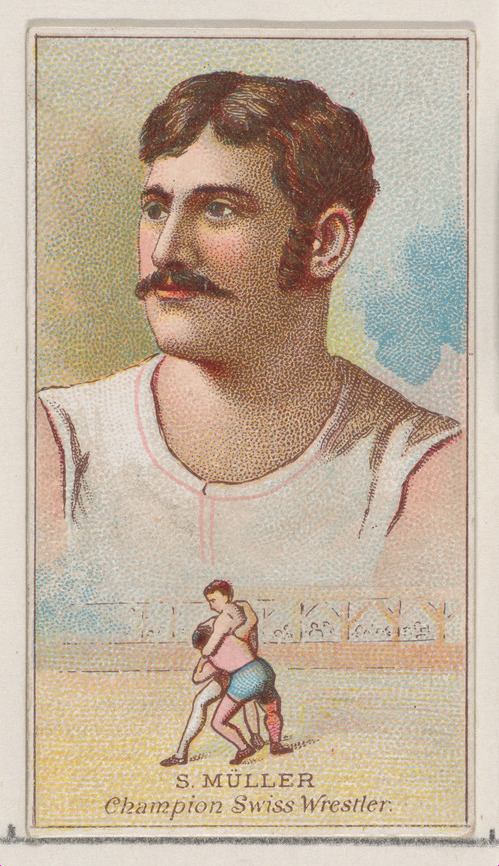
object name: print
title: S. Muller, Champion Swiss Wrestler, from the Champions of Games and Sports series (N184, Type 2) issued by W.S. Kimball & Co.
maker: w.s. kimball & co.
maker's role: publisher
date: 1887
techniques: color lithograph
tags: men,athletes,wrestling